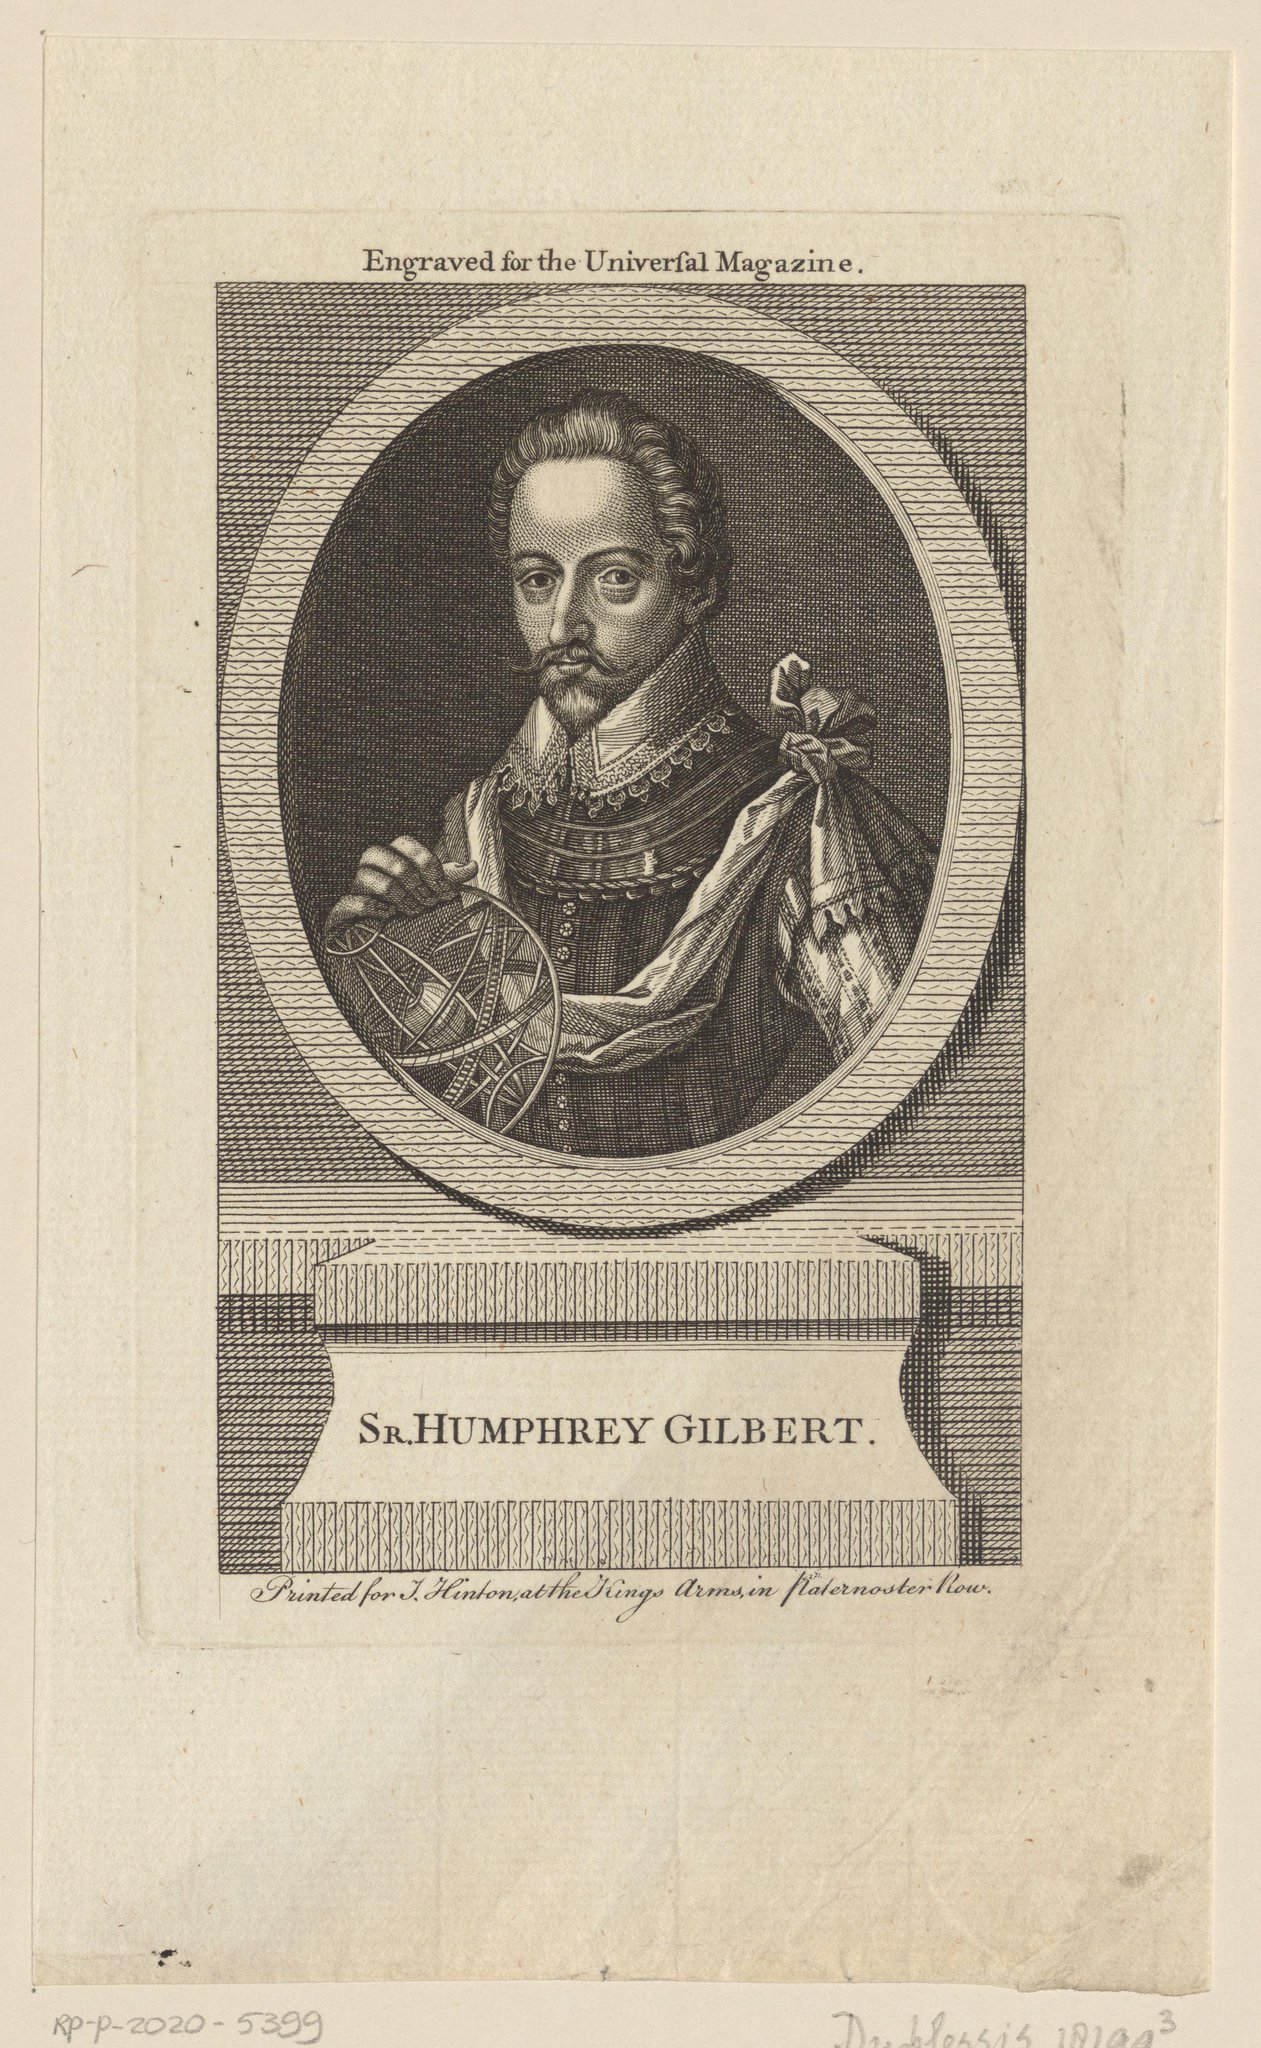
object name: print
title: Portret van Humphrey Gilbert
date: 1747-1781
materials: paper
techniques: engraving, etching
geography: london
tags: explorer (+ portrait of scholar, scientist), historical persons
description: Prent uit: The Universal Magazine of Knowledge and Pleasure, 1747-1781.